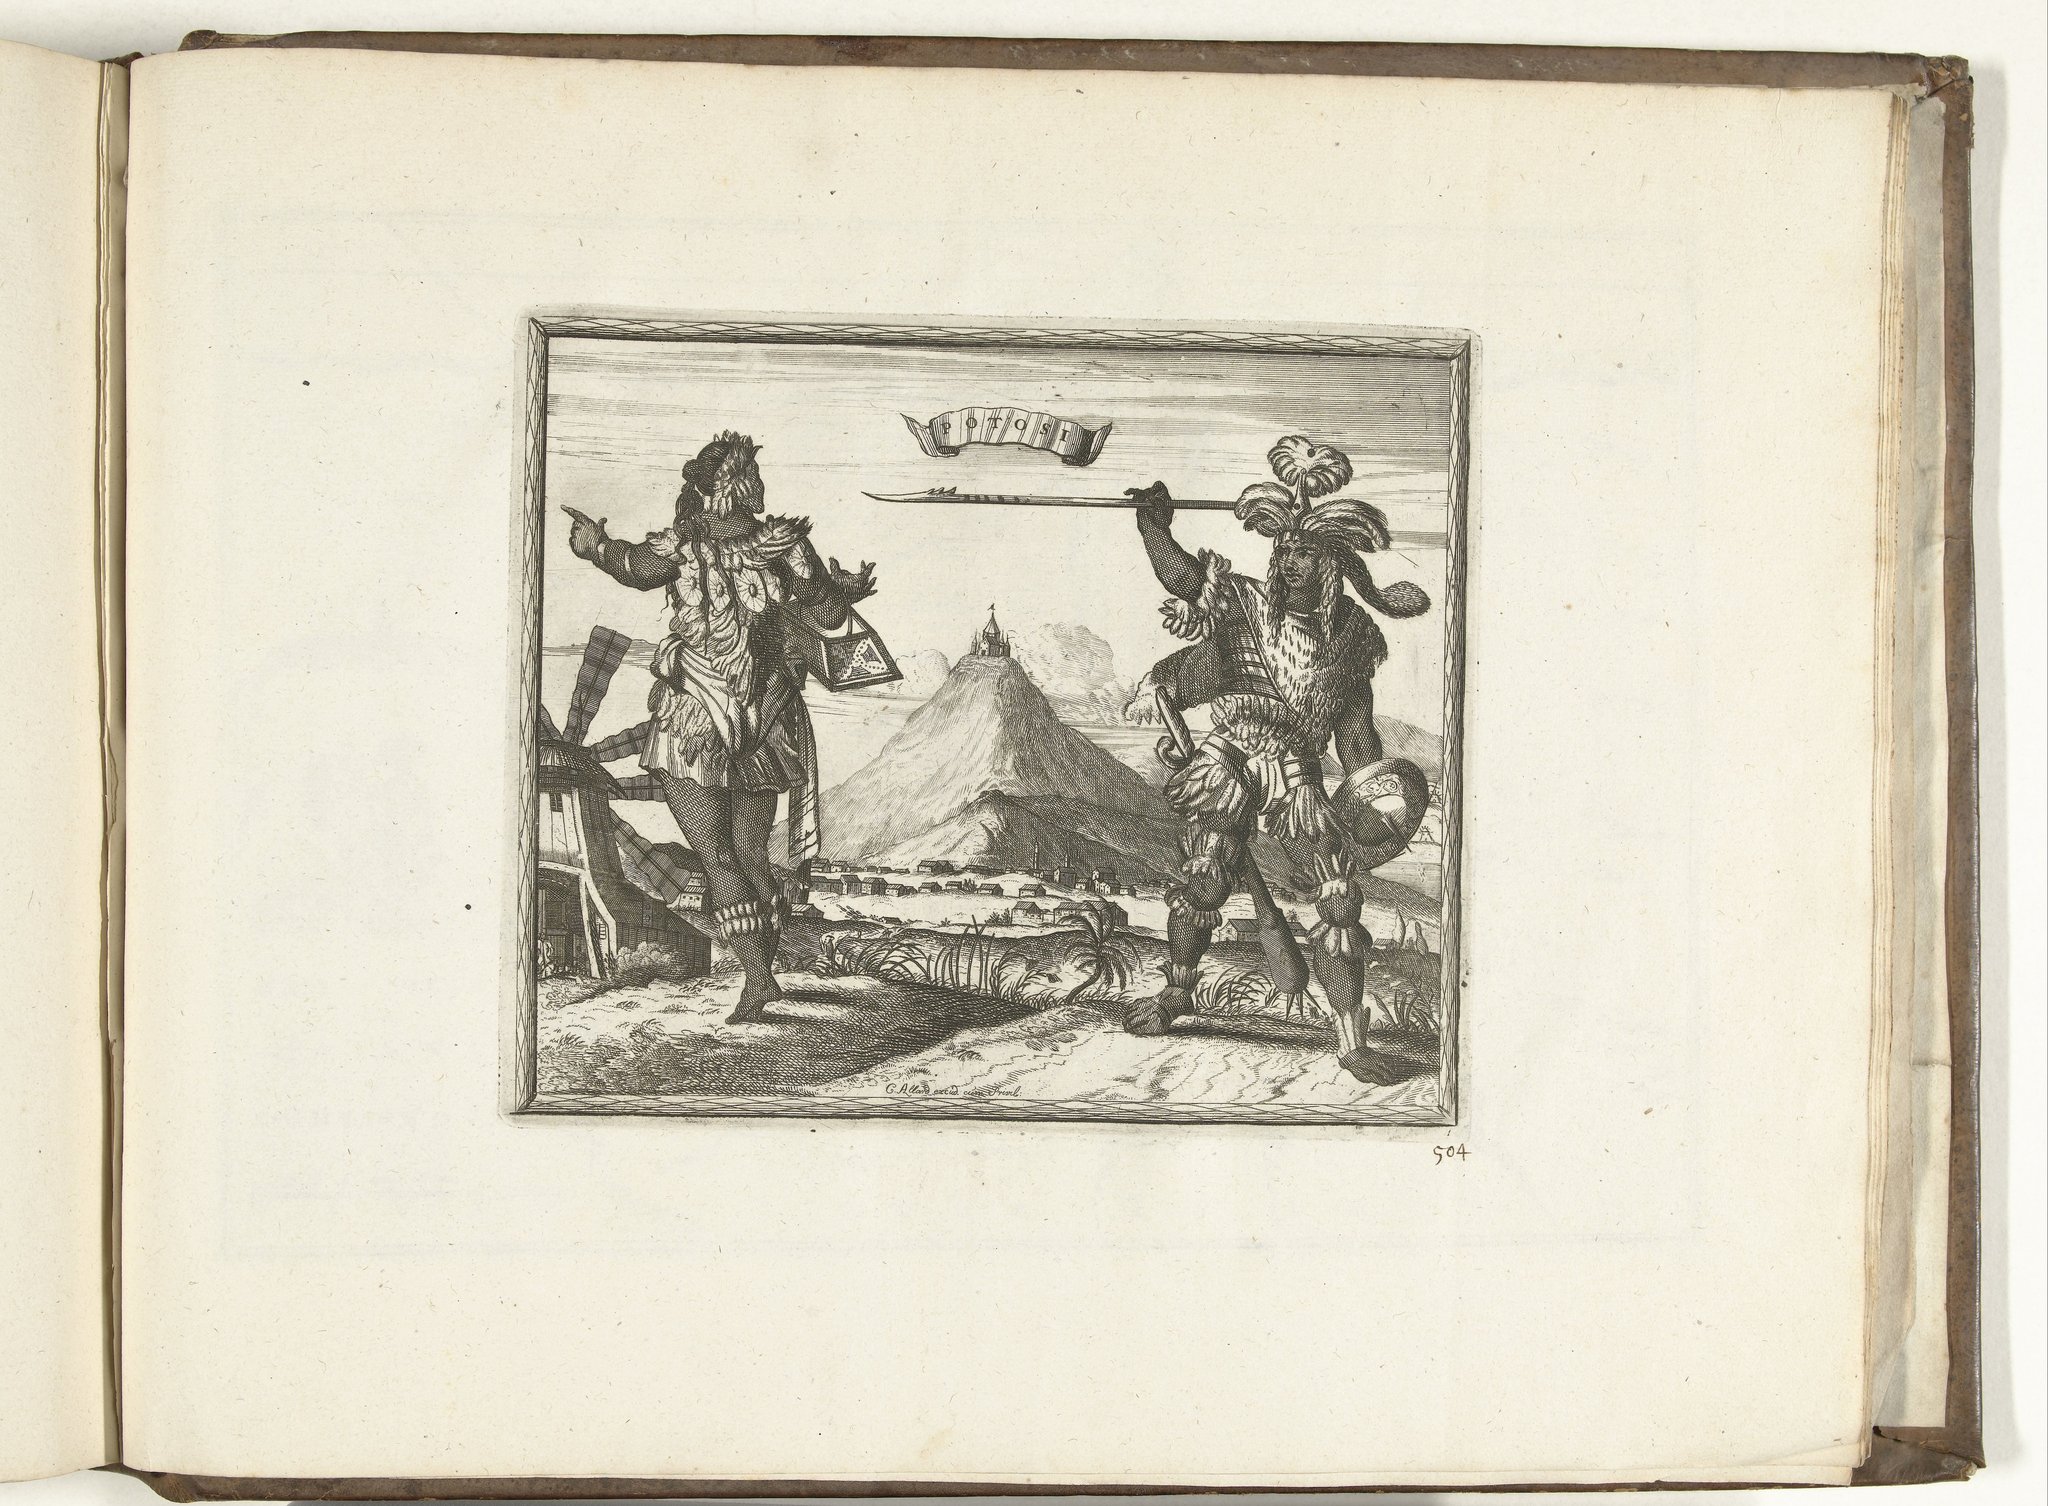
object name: print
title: Les Forces de l'Europe, Asie, Afrique et Amerique (...) Comme aussi les Cartes des Côtes de France et d'Espagne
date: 1726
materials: paper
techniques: engraving, etching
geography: leiden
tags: indigenous peoples of south america, folk costume, regional costume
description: Man en vrouw UIT Potosi in Bolivia, gekleed in lokaal kostuum, op de achtergrond de Cerro Rico (Rijke Berg), een windmolen en de stad. Plaat nr. 504 in deel XX van het prentwerk: Les Forces de l'Europe, Asie, Afrique et Amerique ... Comme aussi les Cartes des Côtes de France et d'Espagne uit 1726, dit tweede deel met 271 met de hand genummerde platen van vermaarde sterke steden en vestingen in het kader van de Spaanse Successieoorlog 1701-1713. Voor het merendeel zijn deze platen gekopieerd naar de anonieme Franse platen van vermaarde sterke steden en vestingen: in Les forces de l'Europe en in: Le theatre de la guerre, dans les Pays-Bas, beide oorspronkelijk uitgegeven door Nicolas de Fer te Parijs (1693-1697) in het kader van de Negenjarige Oorlog.